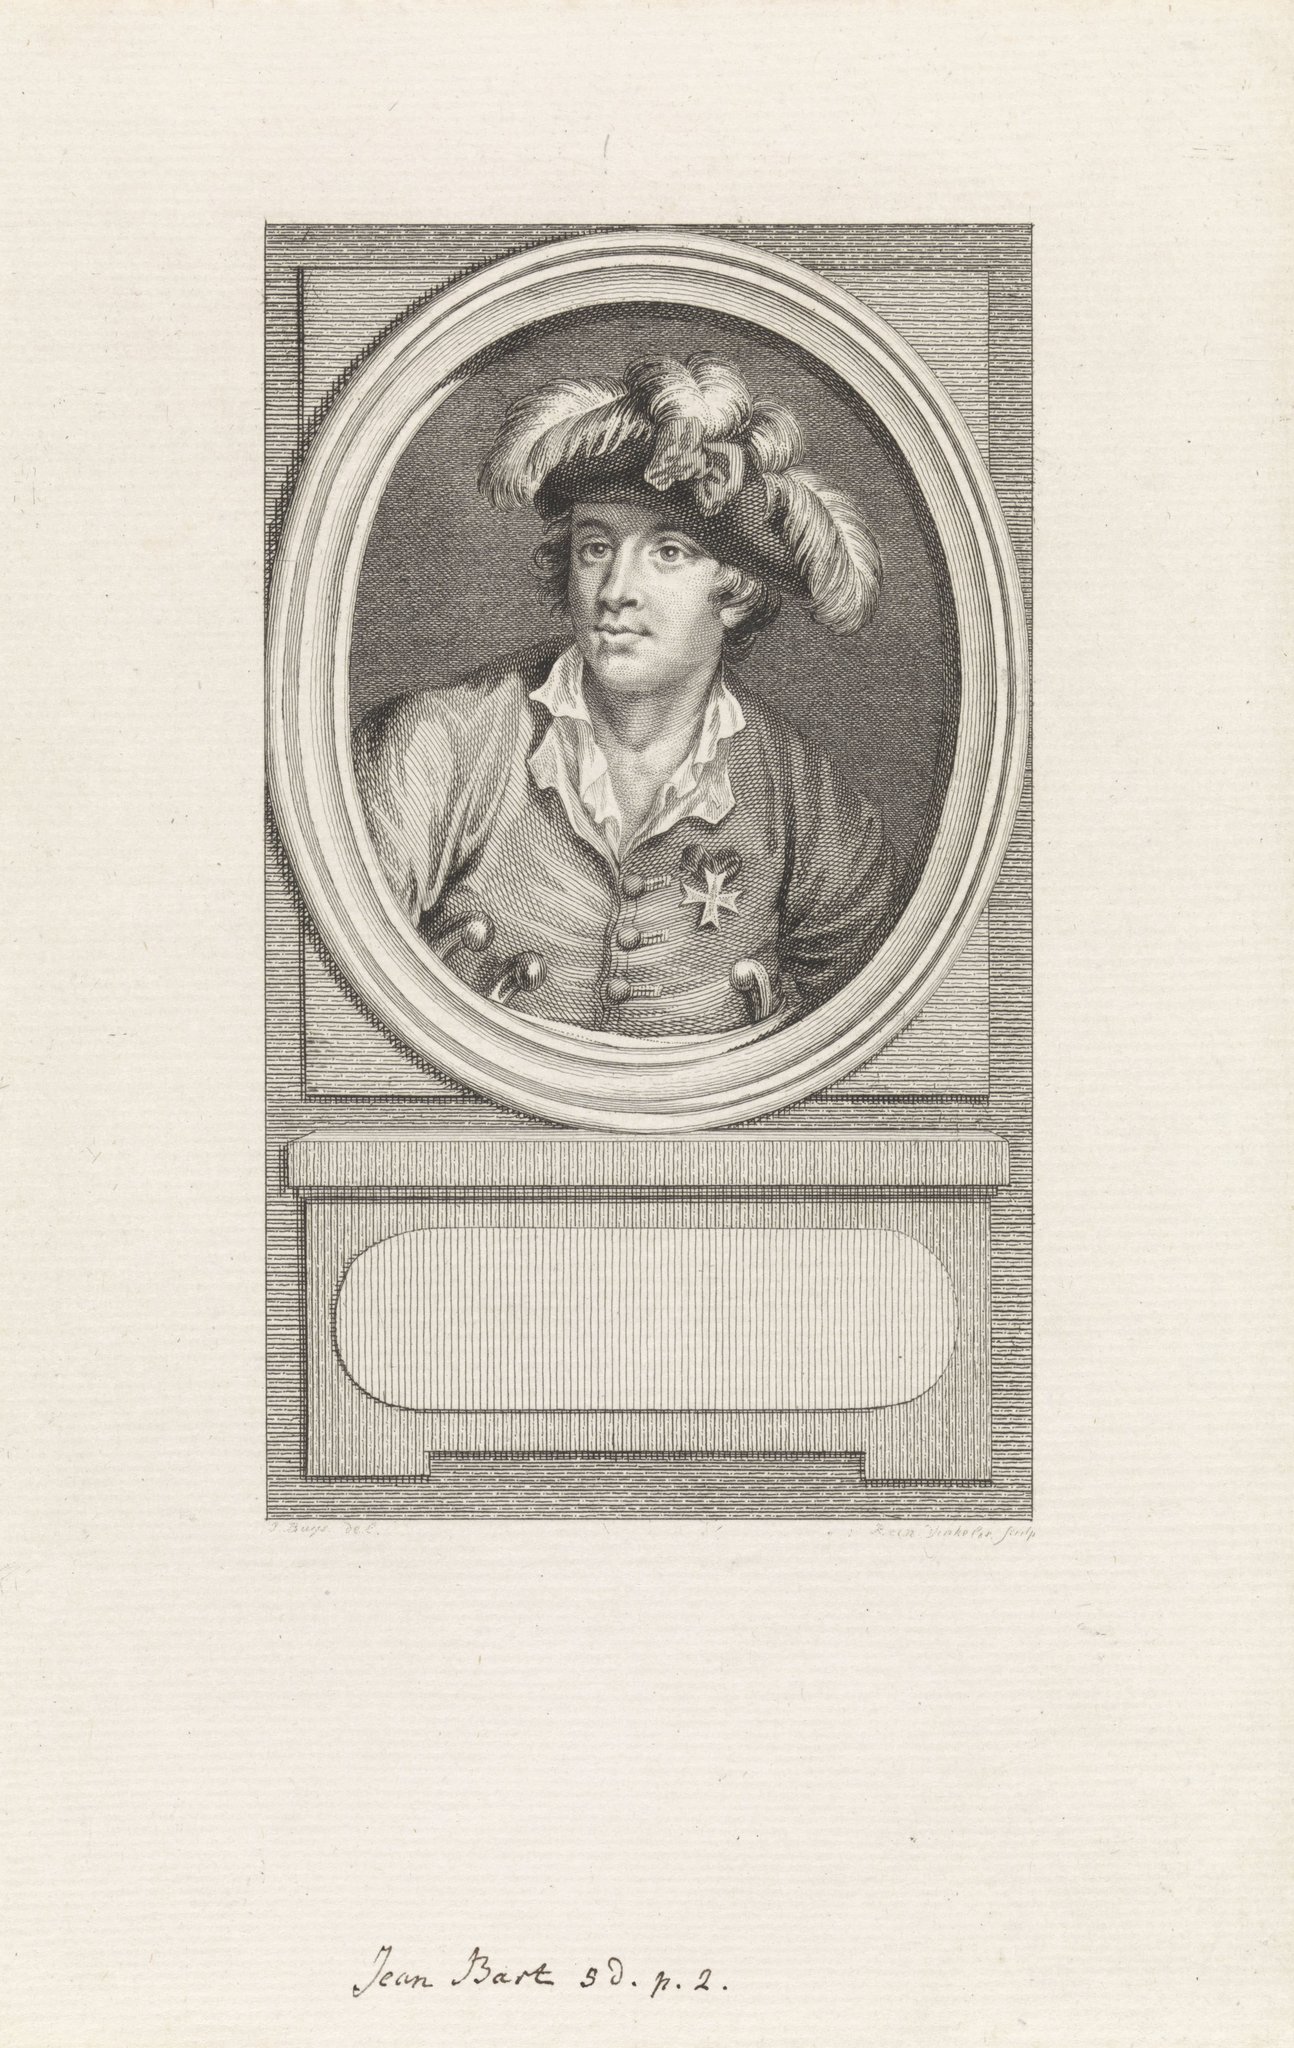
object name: print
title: Portret van Jan Bart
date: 1786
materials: paper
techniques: engraving, etching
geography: amsterdam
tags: duinkerke, kapitein-ter-zee, jan bart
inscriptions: inscription: ‘Jean Bart 5 d. p. 2.’, collector's mark: Lugt 240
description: Latere staat prent gebruikt als boekillustratie in: Kok, Jacobus. Vaderlandsch woordenboek : met kaarten, plaaten en pourtraitten. Amsterdam: Johannes Allart, 1785-1796. Deel V.